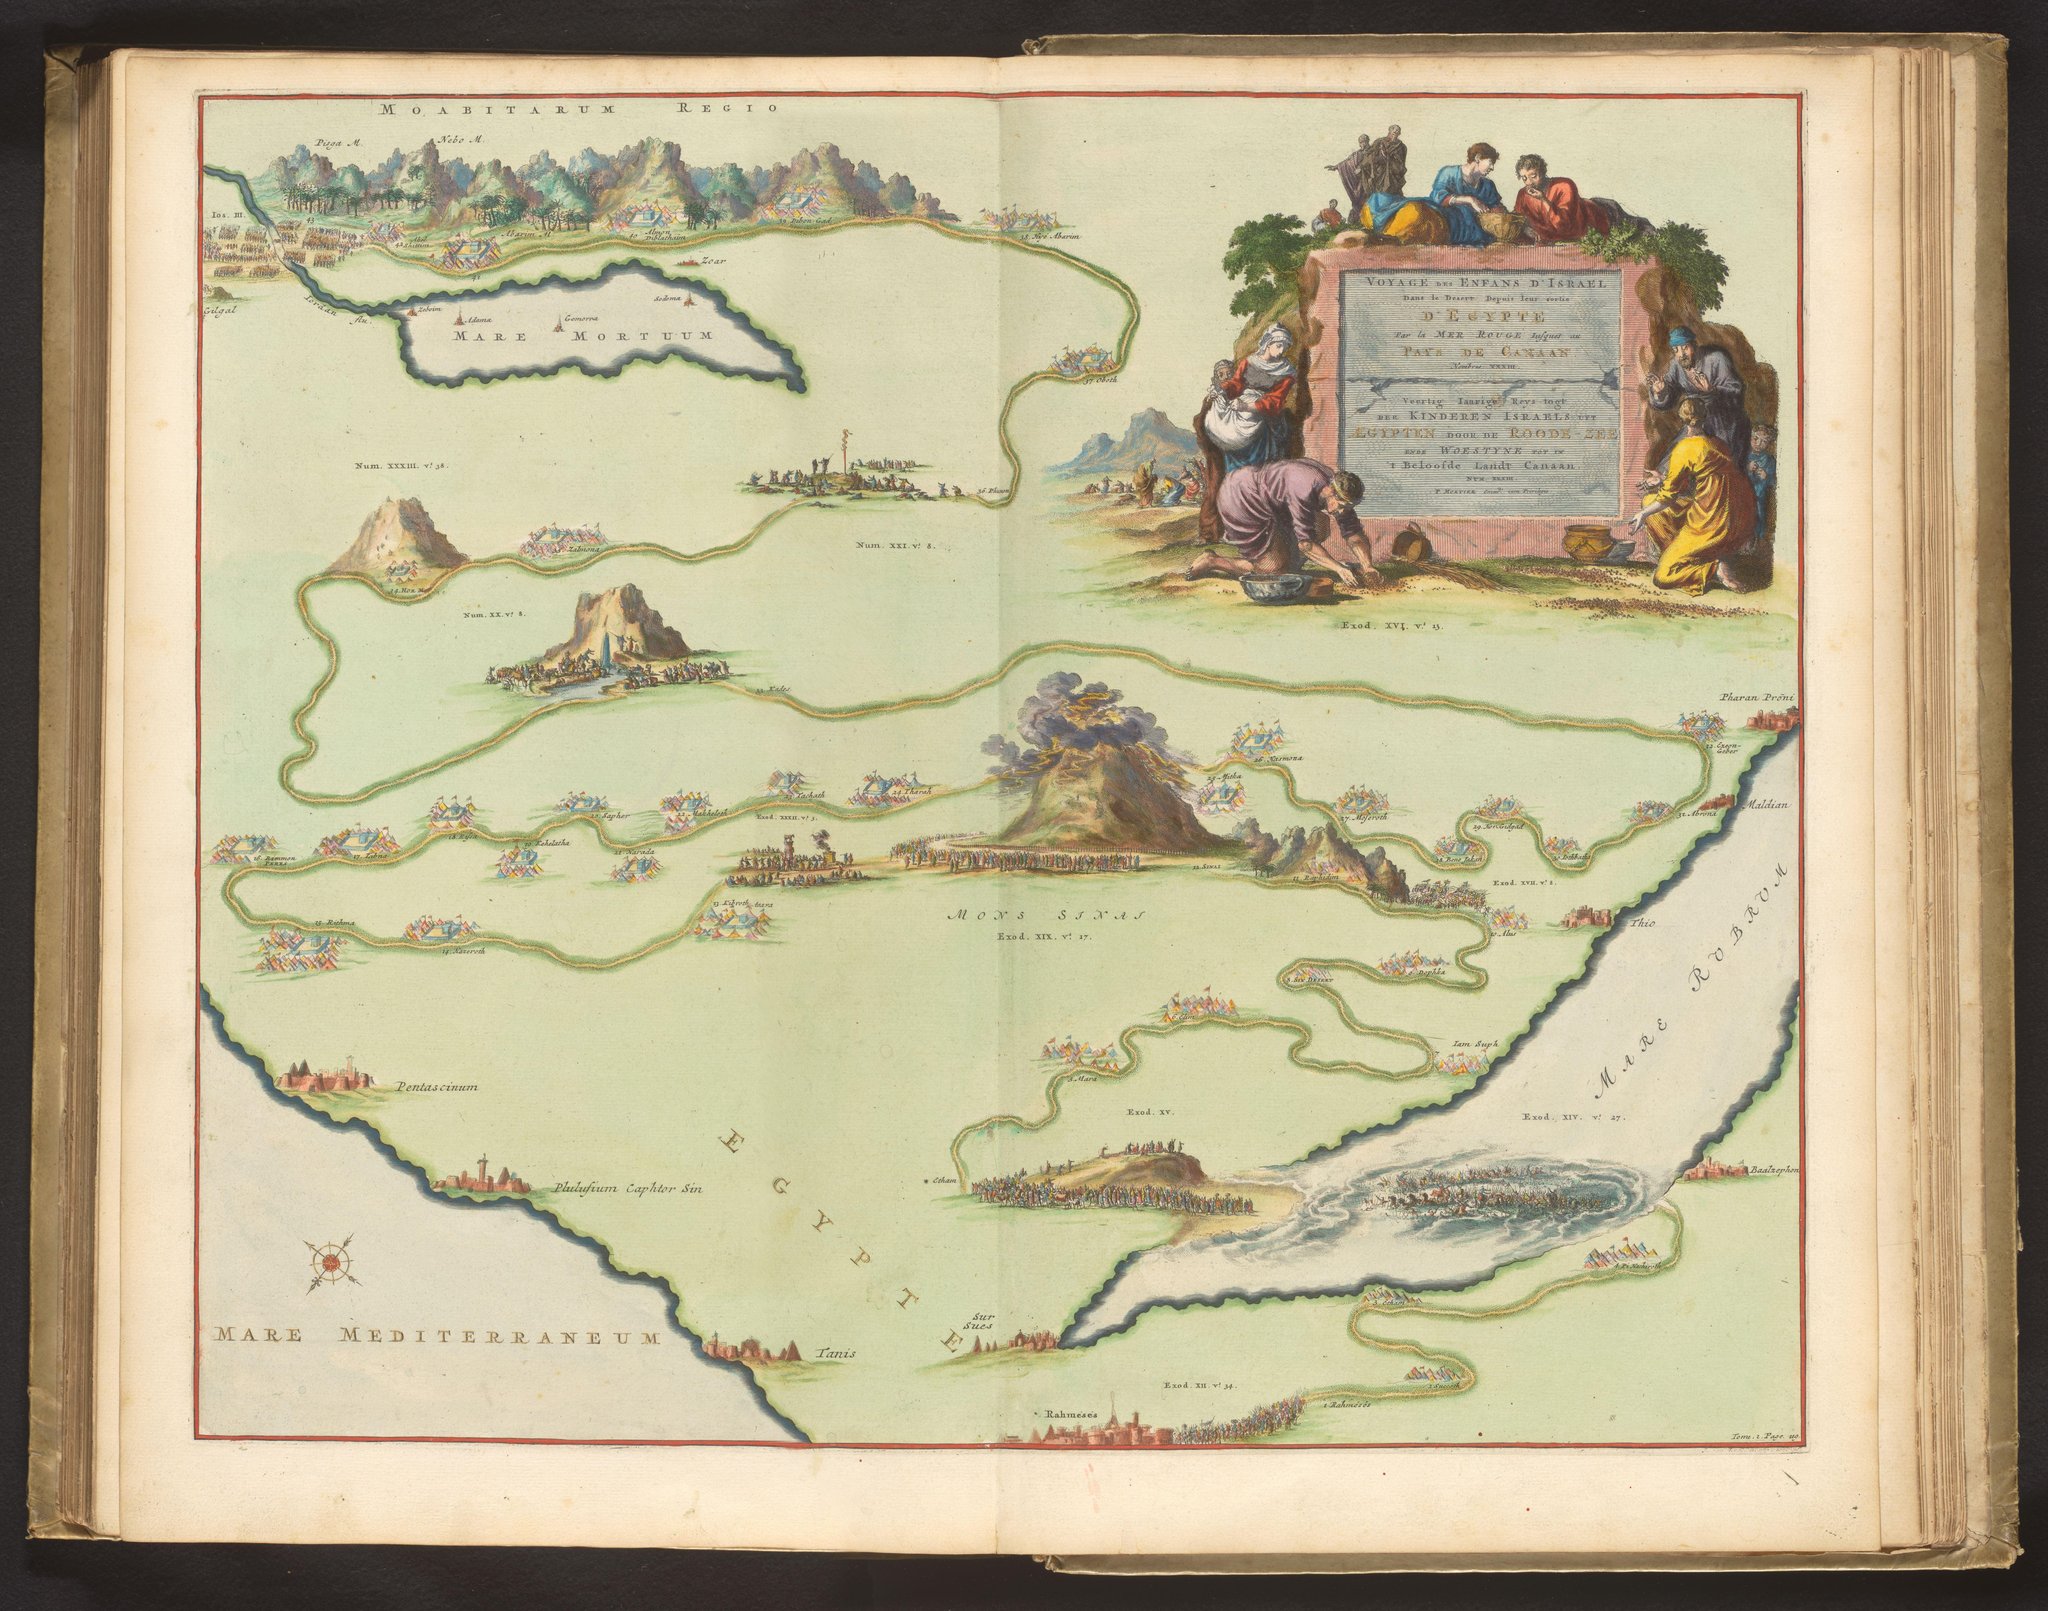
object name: print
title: Voyage des enfans d'Israel dans le desert depuis leur sortie d'Egypte par le Mer Rouge iusques au Pays de Canaan, Nombres XXXIII / Veertig iaarige reys togt der kinderen Israels uyt Aegypten door de Roode-Zee ende woestyne tot in 't beloofde landt Canaan, Num. XXXIII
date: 1700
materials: paint, paper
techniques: engraving, hand coloring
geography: amsterdam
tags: maps of separate countries or regions, the gathering of manna (in baskets and pots), exodus, leviticus, numbers, deuteronomy, joshua: from the bondage of the israelites in egypt to their settlement in canaan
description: Kaart van de 40-jarige tocht van de Israëlieten uit Egypte naar het Beloofde Land. Rechtsboven een cartouche met de titels met daarbij figuren die het gevallen manna verzamelen. Rechtsonder: Tom. 1, pag. 110. Uitvouwbare kaart in het tweede deel van de prentbijbel met het Nieuwe Testament, uitgegeven door Pieter Mortier, Amsterdam 1700.